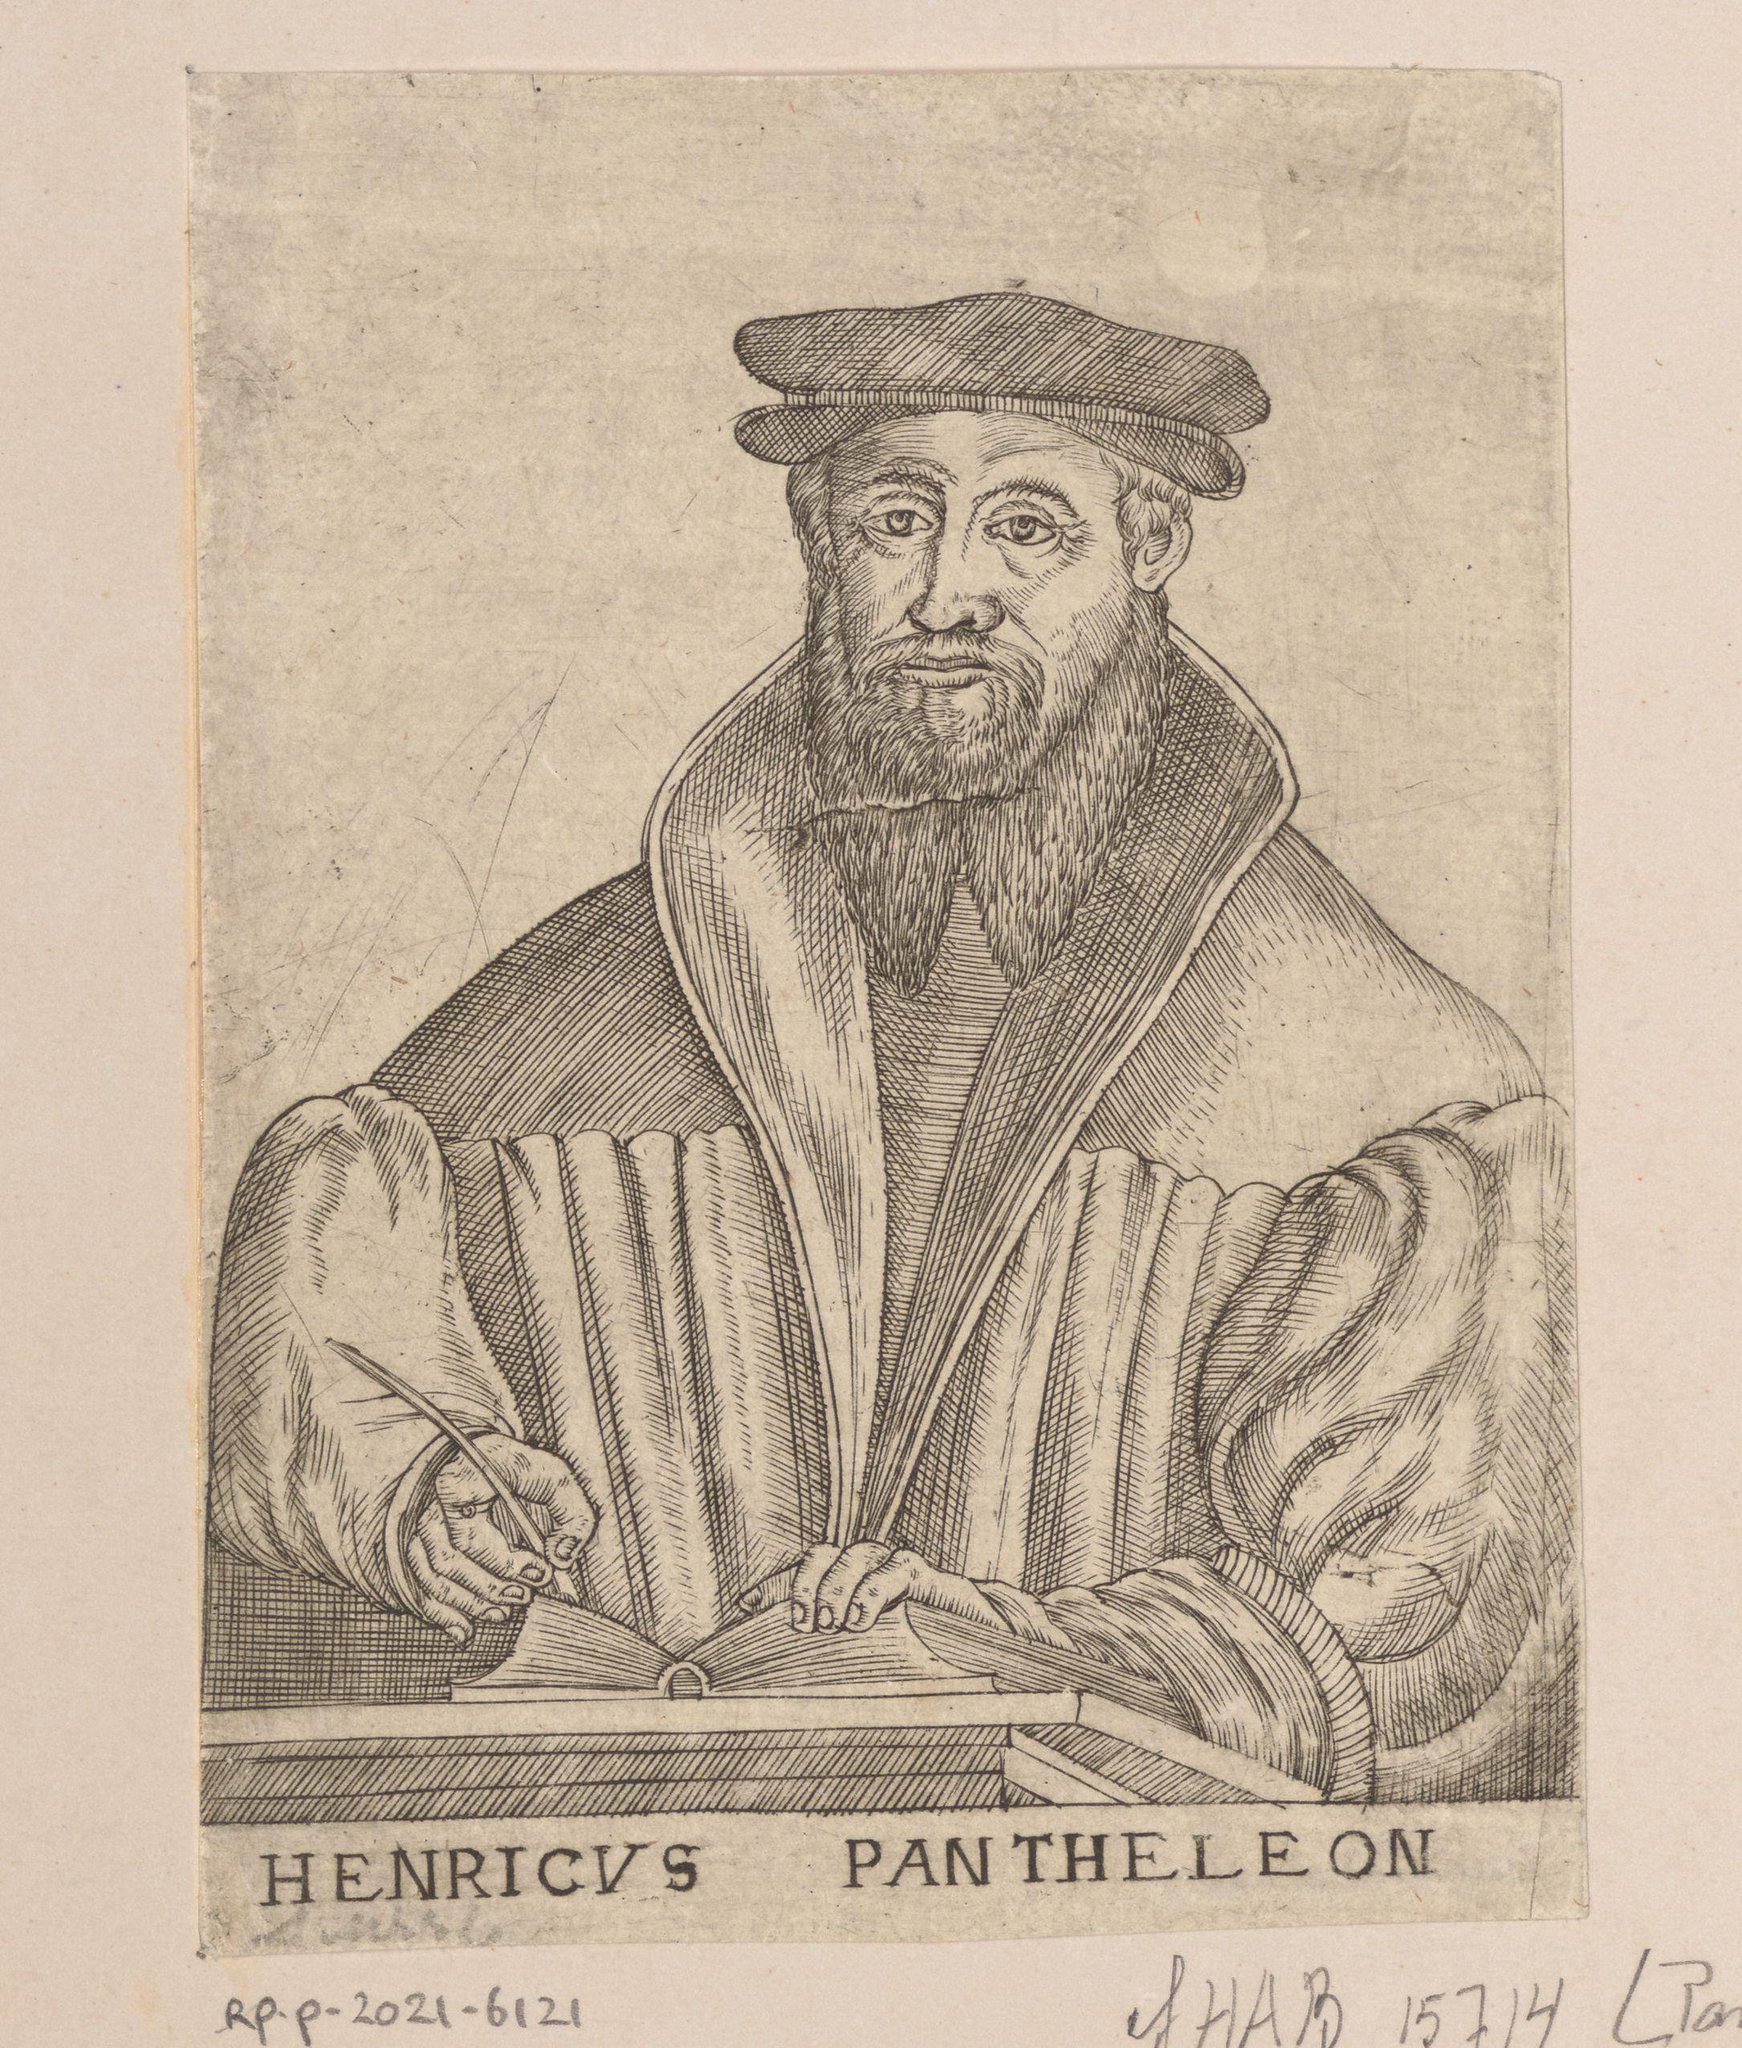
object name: print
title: Portret van Heinrich Pantaleon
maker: Anonymous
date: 1550-1699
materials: paper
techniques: engraving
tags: adult man, historical persons, writing accessories